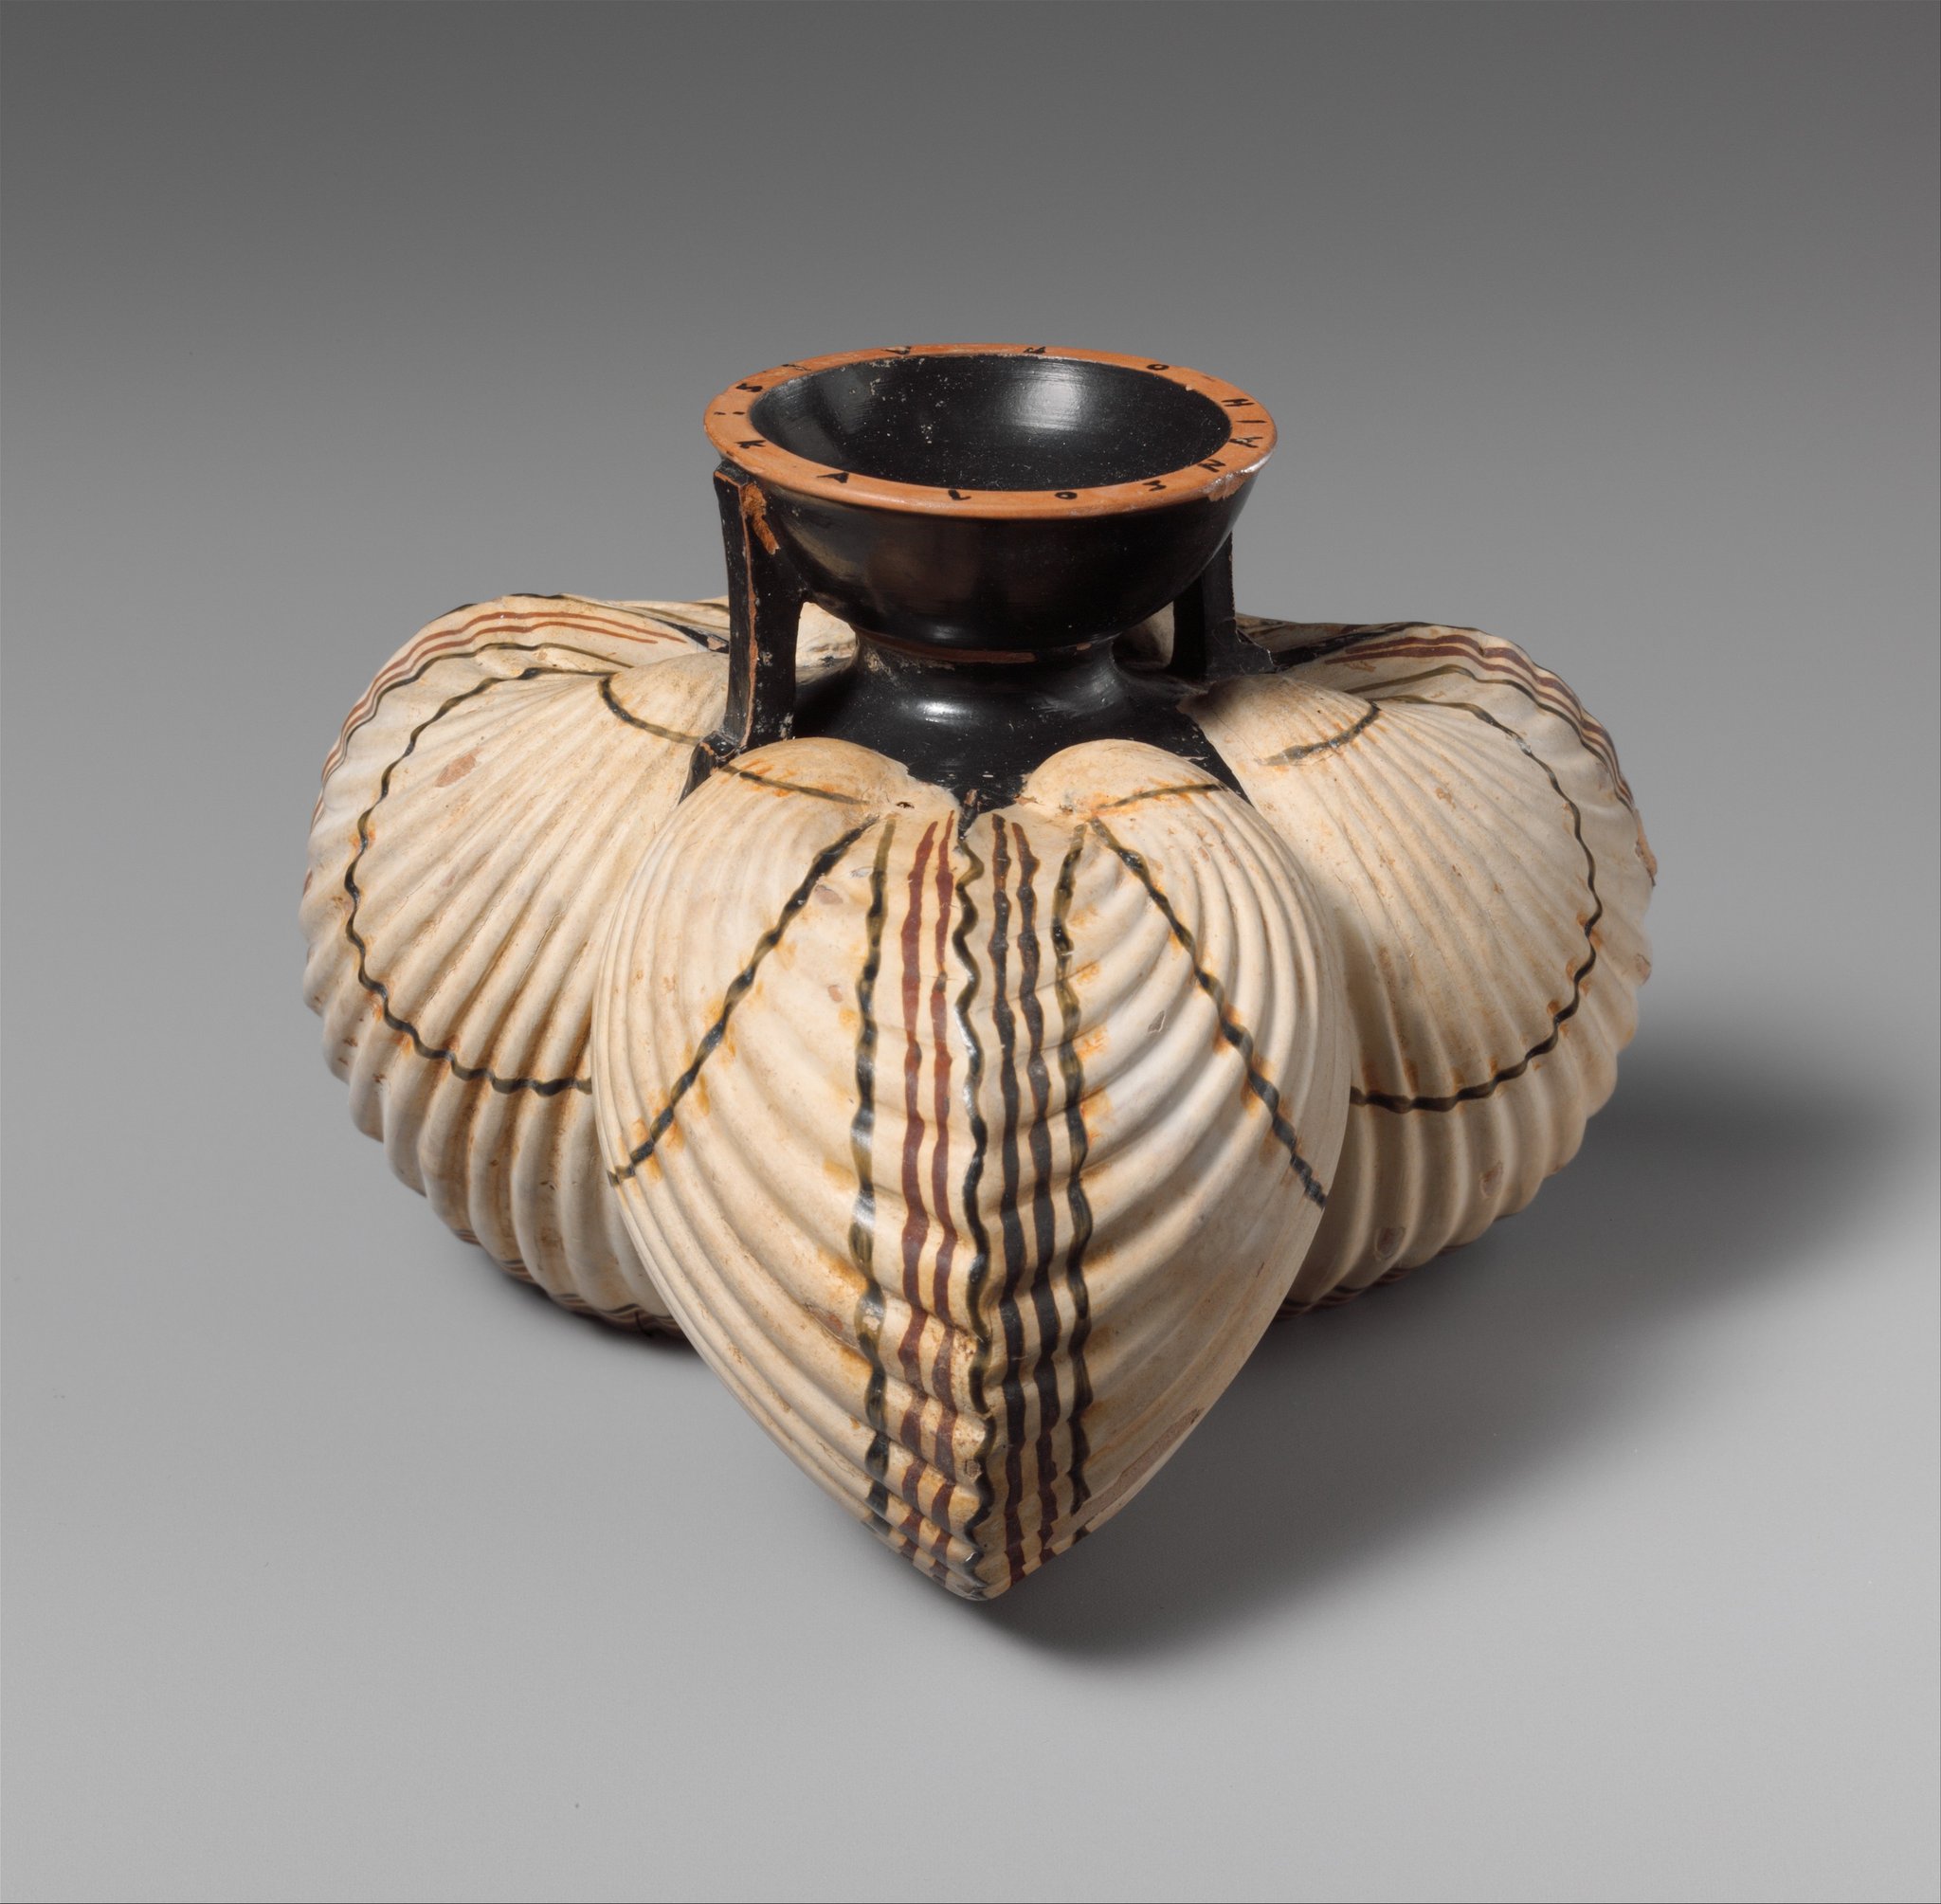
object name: aryballos in the form of three cockleshell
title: Terracotta aryballos (oil flask) in the form of three cockleshells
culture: greek, attic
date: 534-501 BCE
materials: terracotta